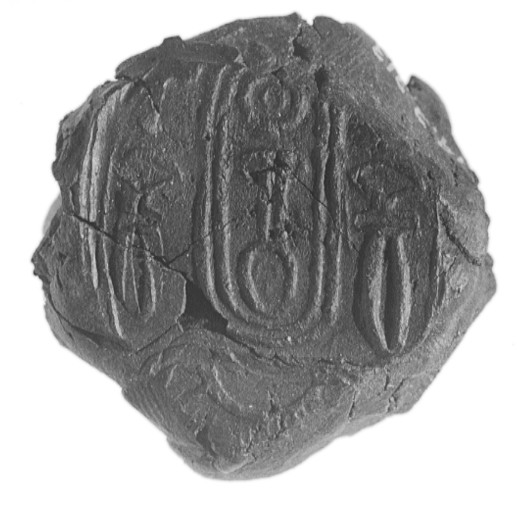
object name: sealing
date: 2030-1640 BCE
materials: clay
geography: egypt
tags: hieroglyphs